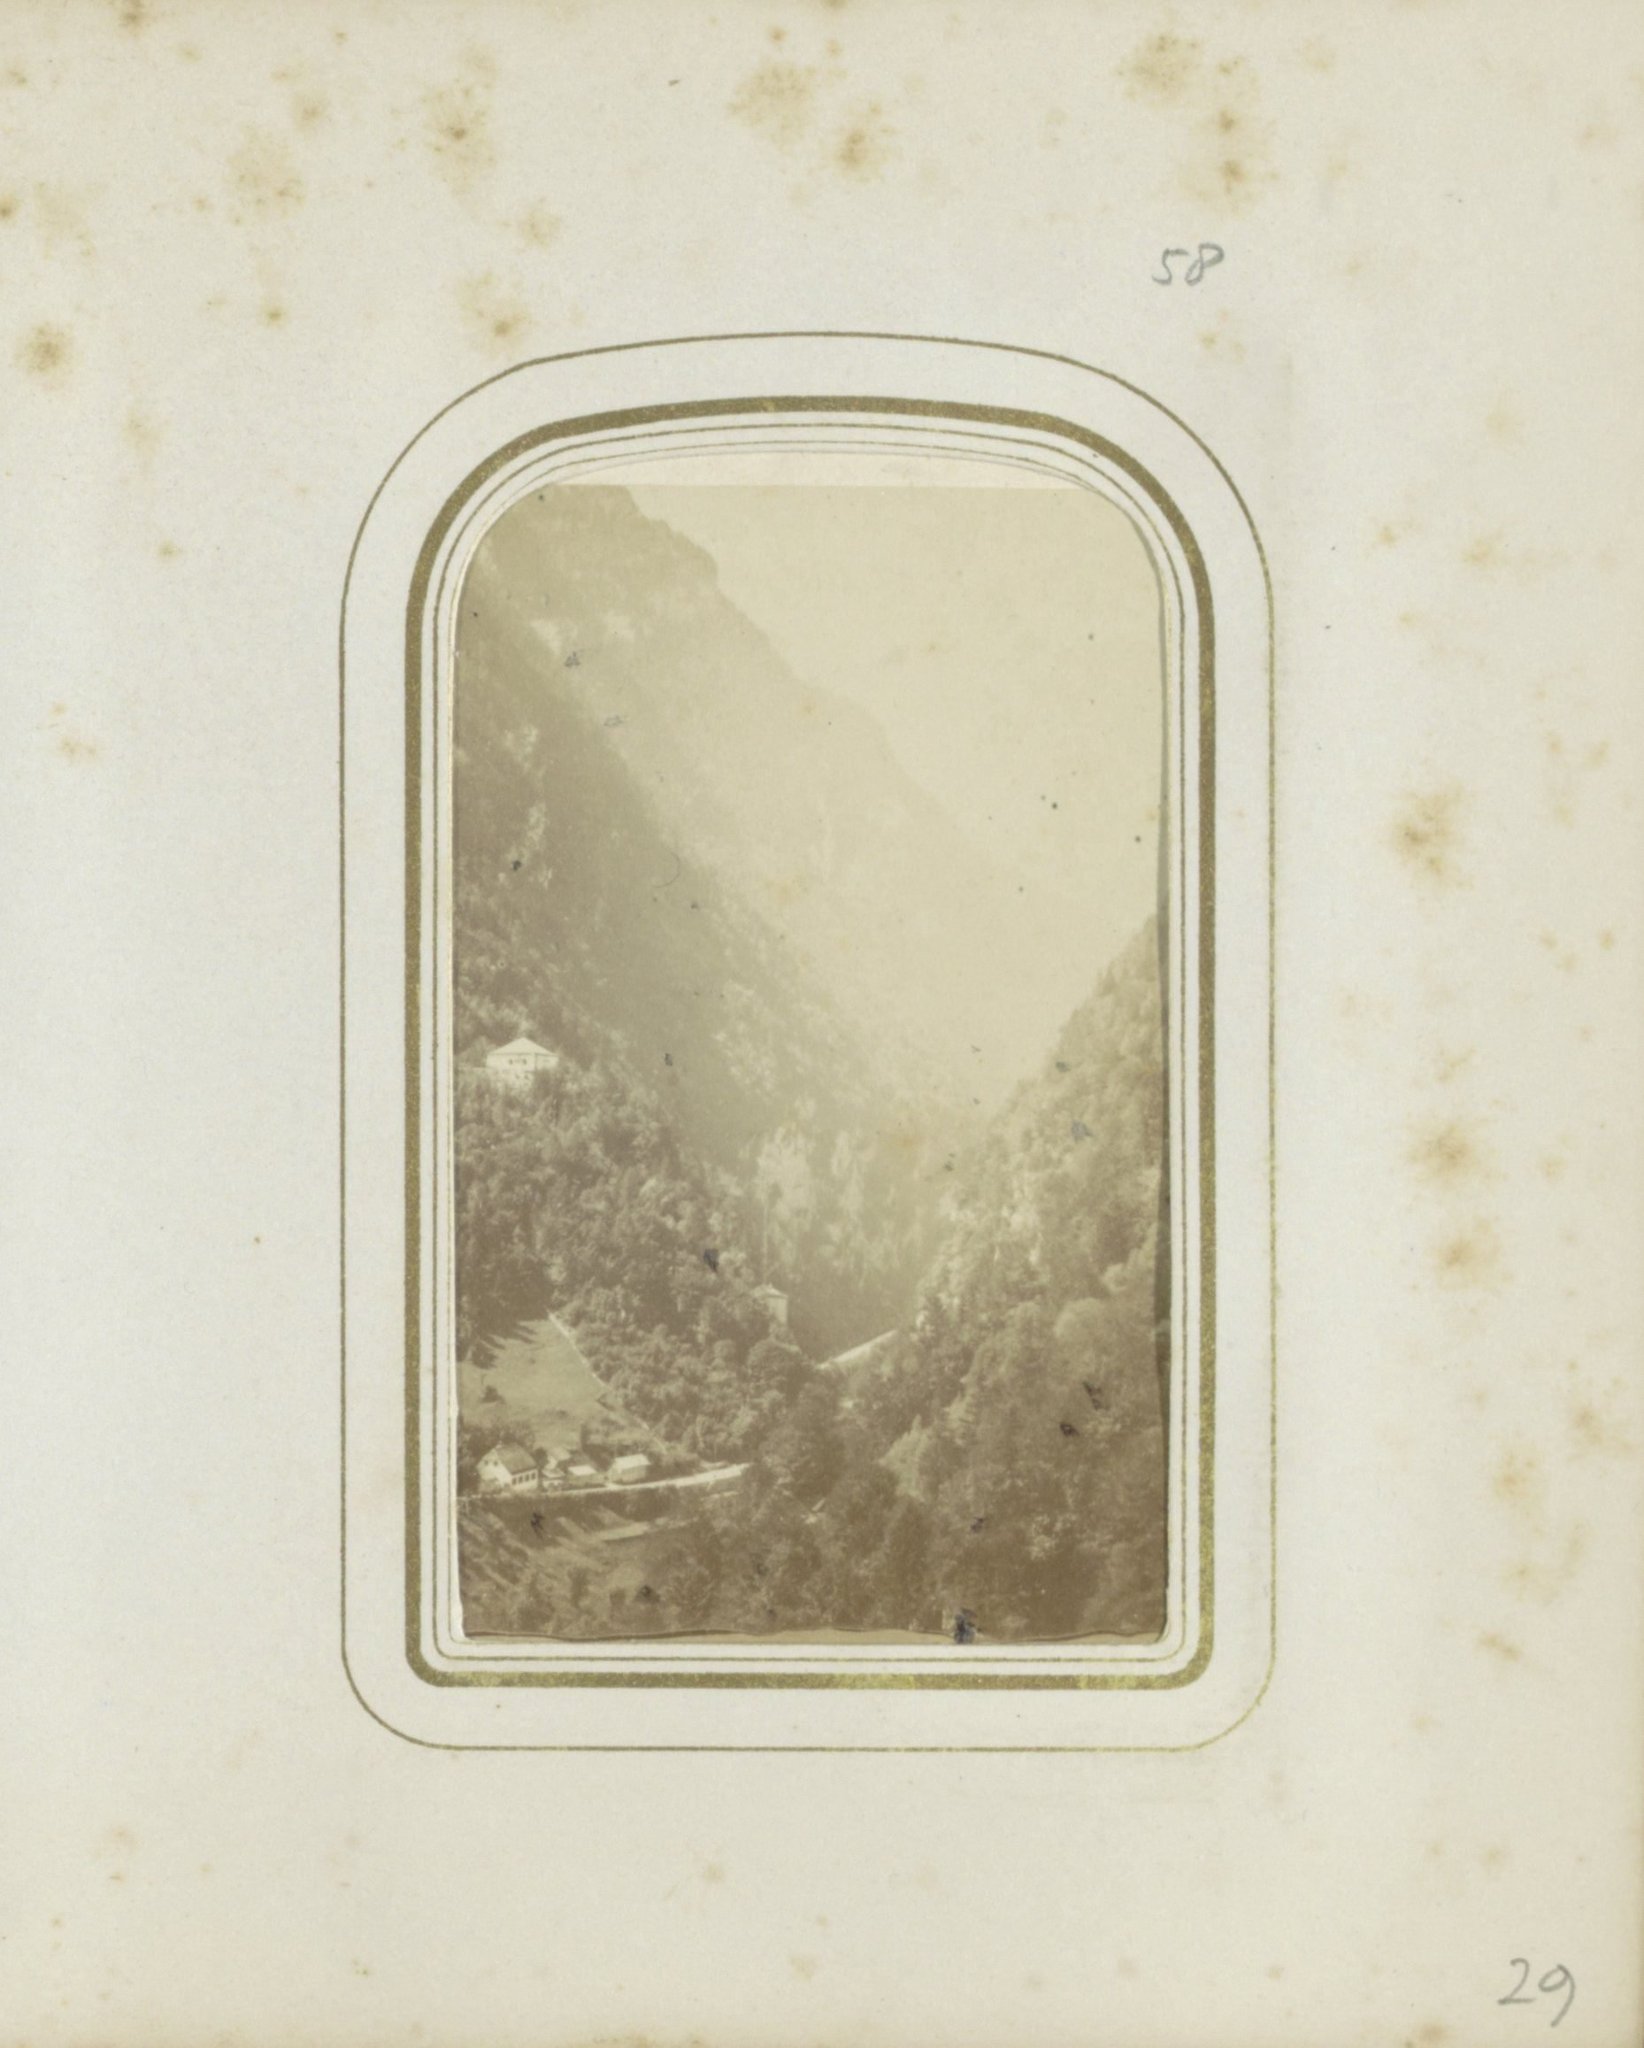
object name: photograph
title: Gezicht op de bergpas van Pass Lueg in de Oostenrijkse Alpen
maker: Anonymous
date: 1865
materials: paper, photographic support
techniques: albumen print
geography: alps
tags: road, path, travelling; tourism, mountains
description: Onderdeel van Fotoalbum van een reis door Zwitserland, Oostenrijk en Duitsland door de Nederlandse familie Derkinderen.